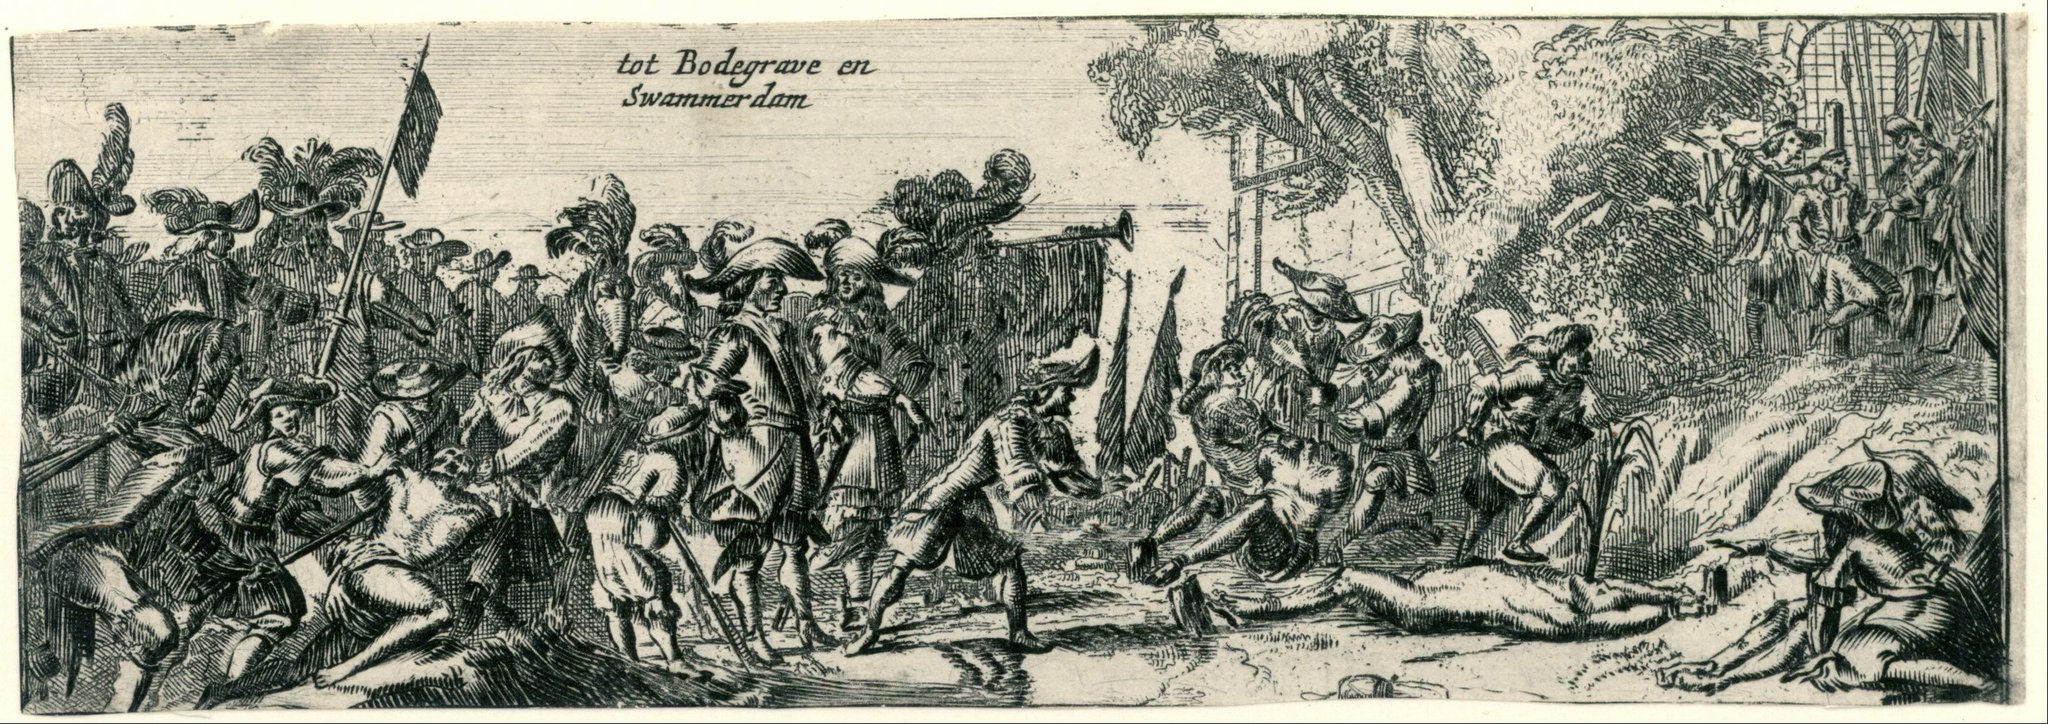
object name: print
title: tot Bodegrave en Swammerdam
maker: Anonymous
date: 1673-1674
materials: paper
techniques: engraving, etching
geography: northern netherlands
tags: violent death, being killed; being mishandled and maltreated; seeking death, massacre ~ war, bodegraven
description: Voorstelling van de wreedheden bedreven door de Franse troepen in de Hollandse dorpen Bodegraven en Zwammerdam in het jaar 1672, In de voorstelling worden personen op verschillende manieren gemarteld en omgebracht. De prent is een verkleinde kopie naar de illustratie van Romeyn de Hooghe uit 1673 (FM 2439/1) in A. de Wicquefort, 'Getrouw Advys aen de oprechte Hollanders rakende het geene gepasseert is inde Dorpen van Bodegrave en Swammerdam', 1674.